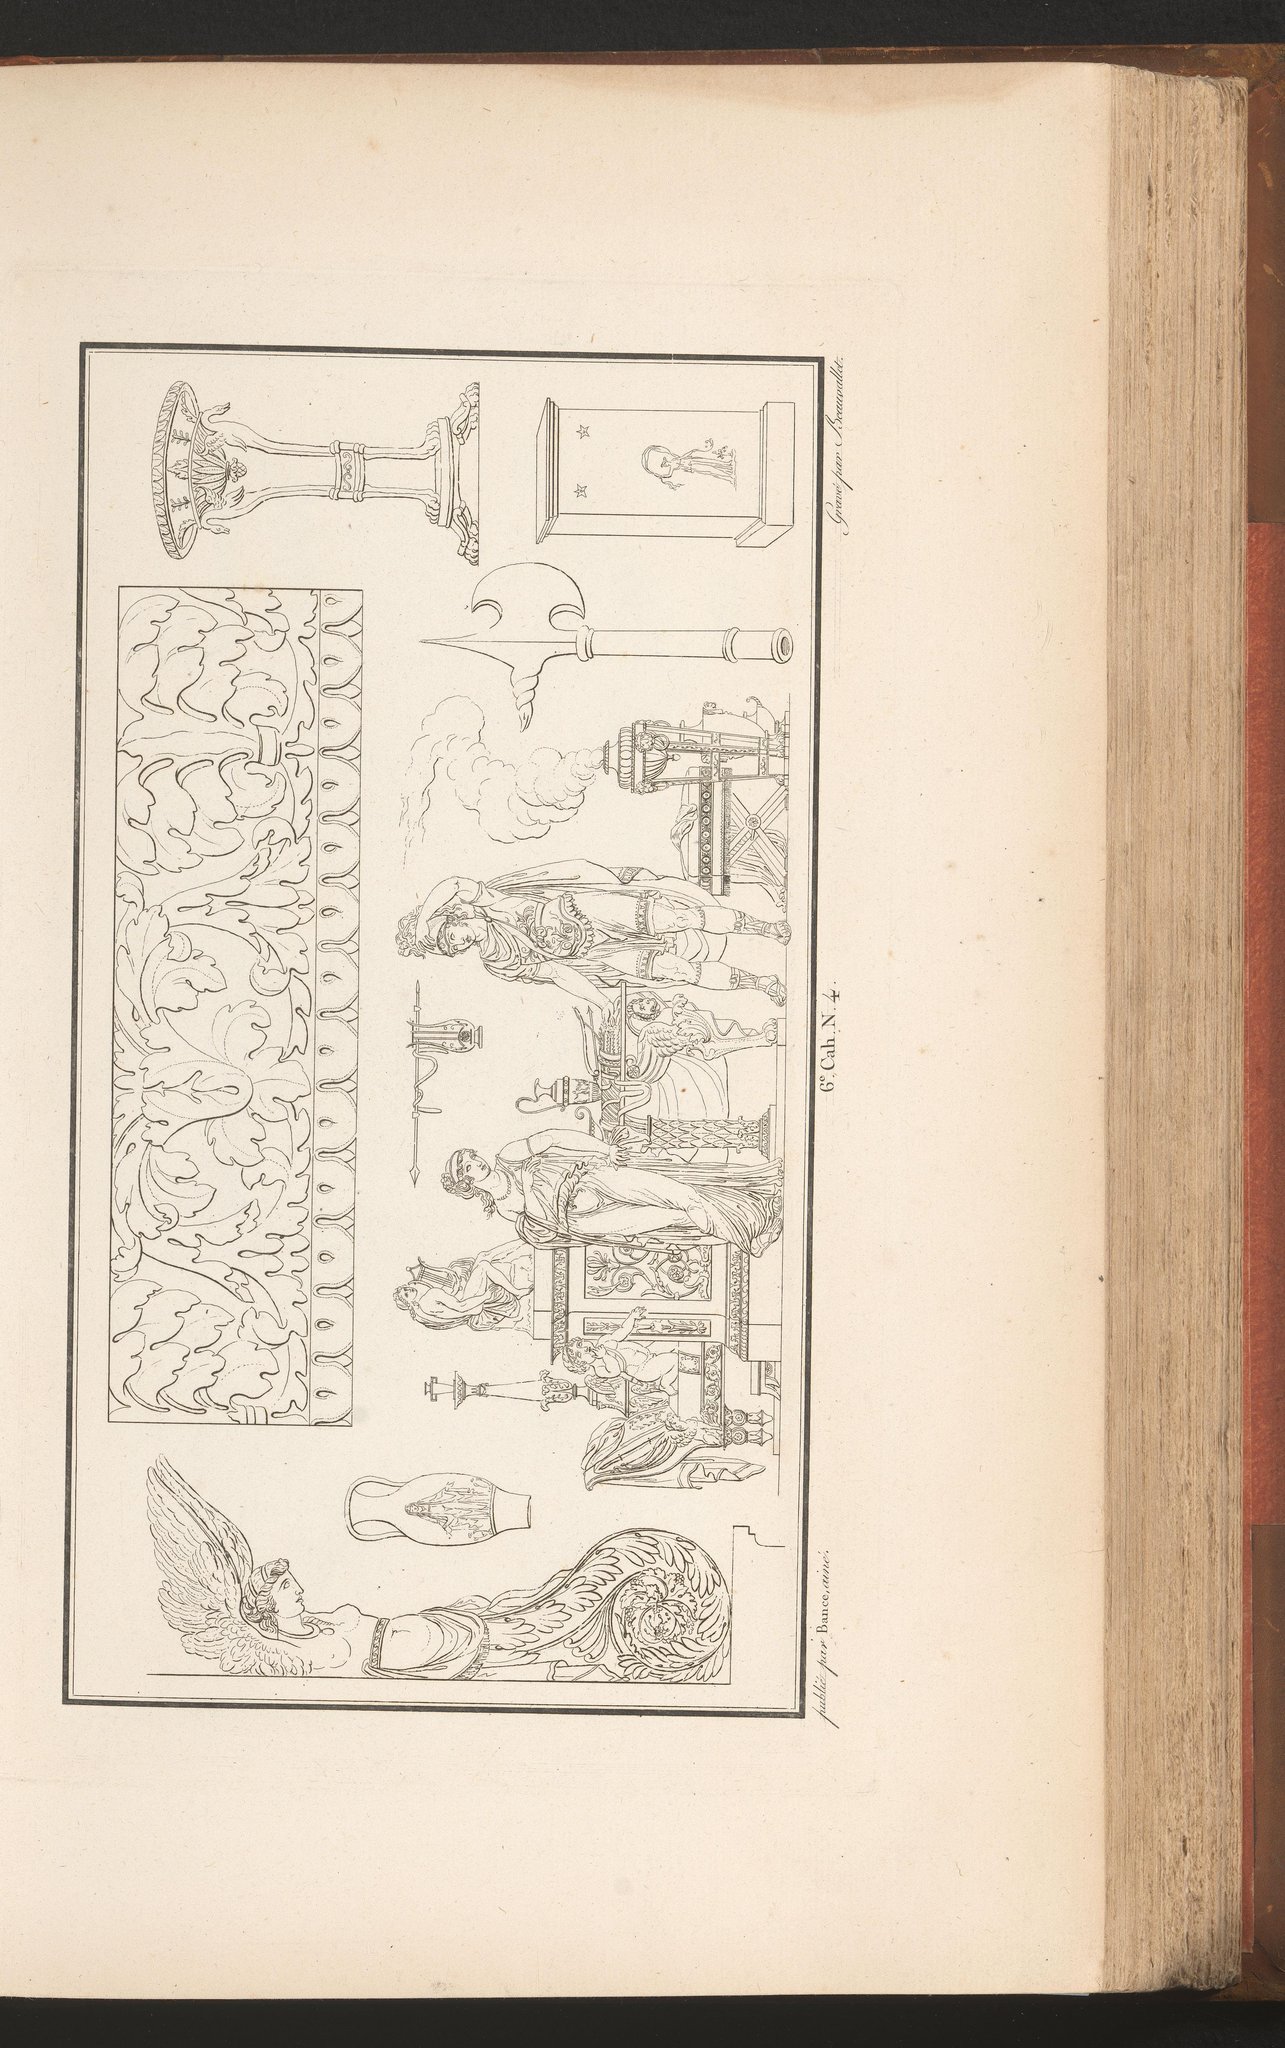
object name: ornament print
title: Twee figuren bij een brandend altaar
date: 1820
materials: paper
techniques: etching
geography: paris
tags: ornaments ~ art, house-altar ~ roman religion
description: Ornamentprent met centraal twee figuren bij een brandend altaar, met andere altaren en reliëfwerk. Onderdeel (6e. Cah. N. 4) van het prentalbum met twee series van in totaal 138 ornamentprenten door Beauvallet en Normand, 'Fragmens d'Ornemens dans le Style Antique'.